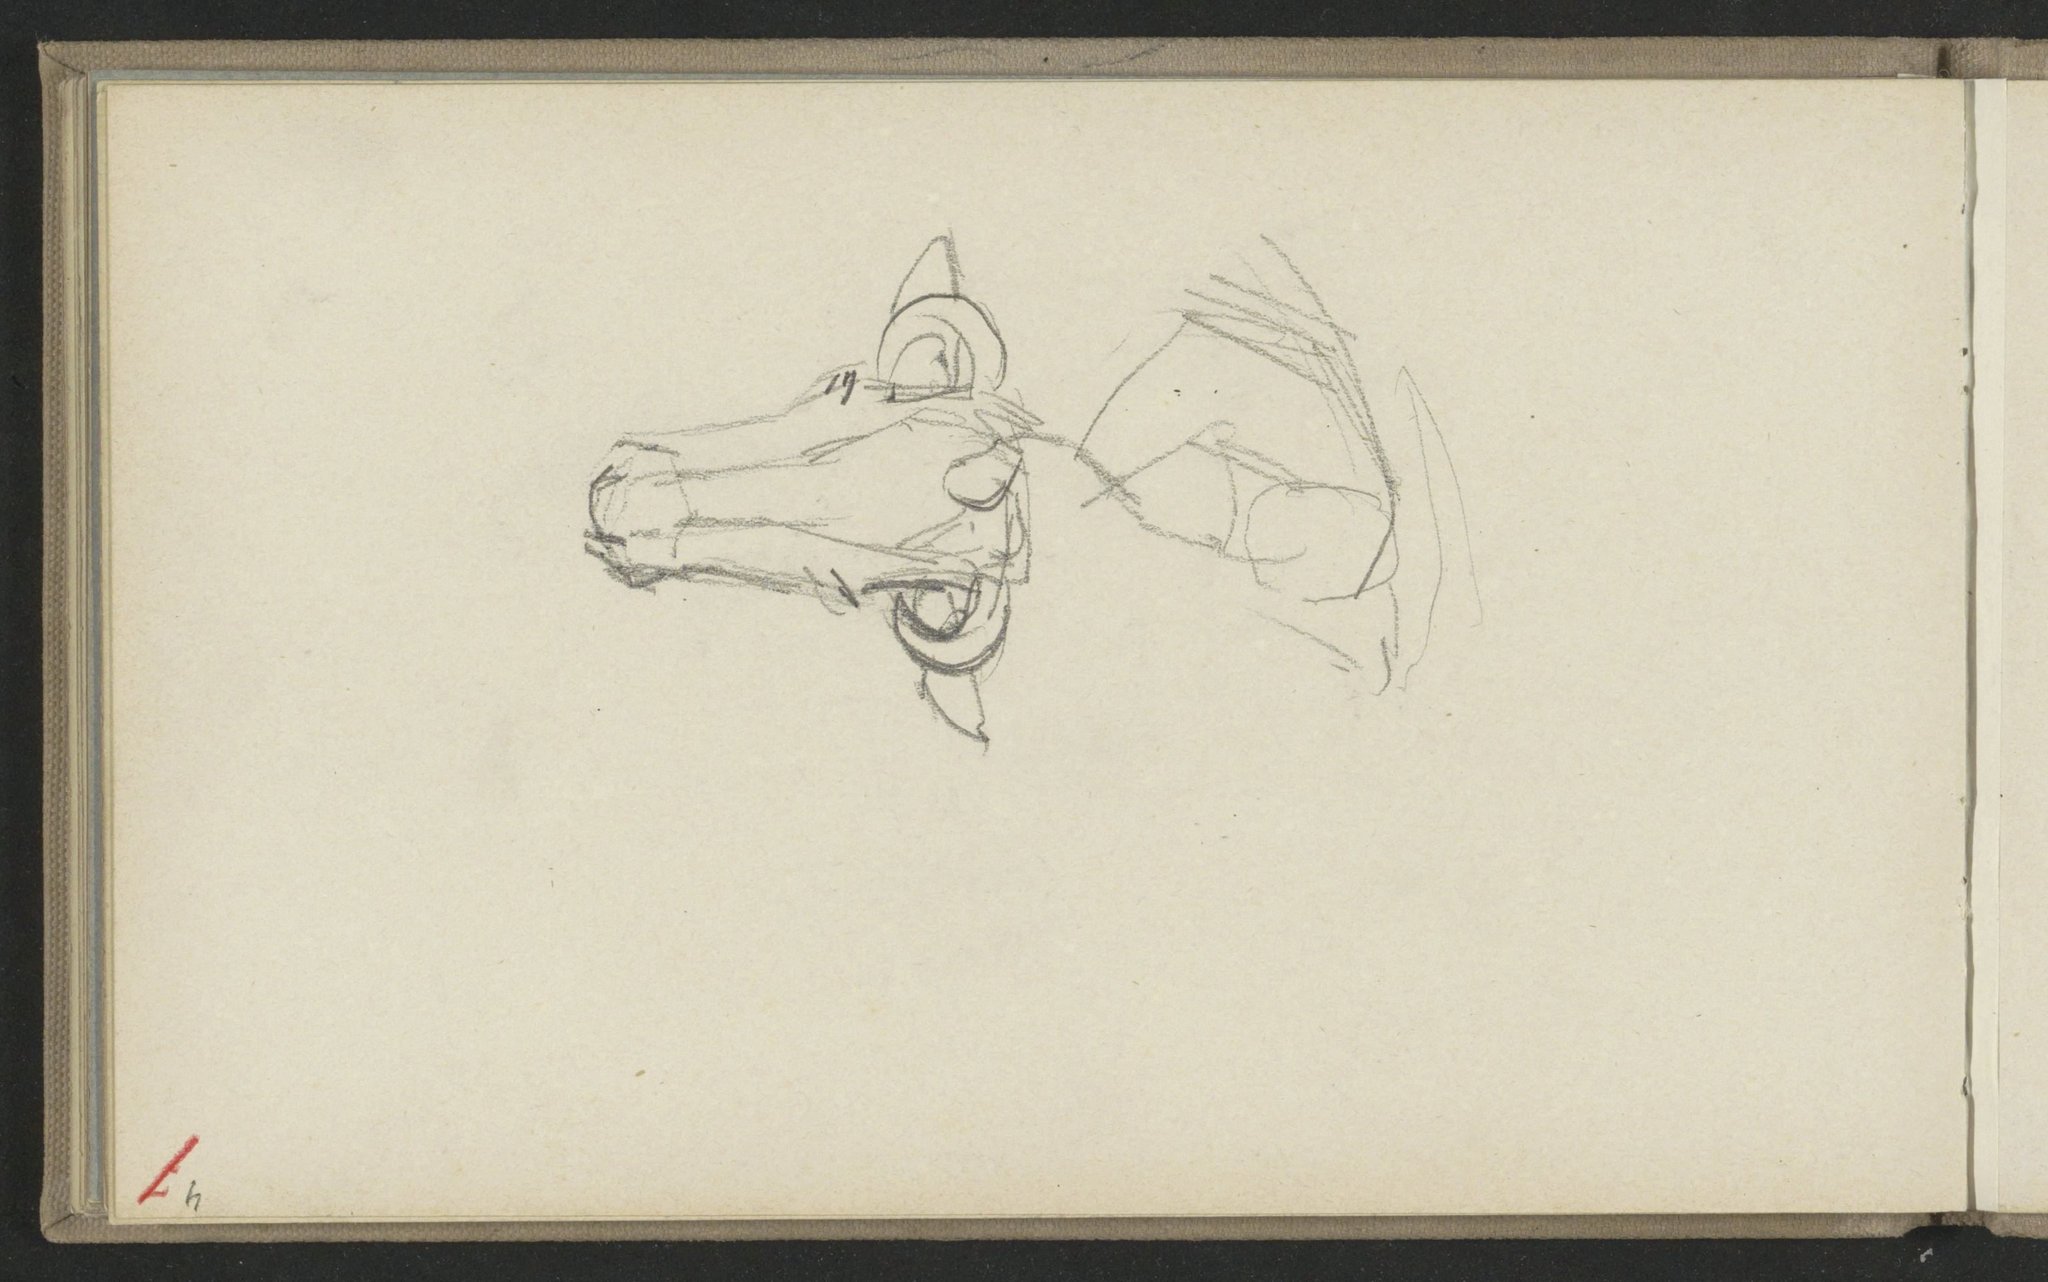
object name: sketchbook leaf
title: Kop van een koe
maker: jozef israëls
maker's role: draughtsman, painter, print maker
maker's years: 1824-1911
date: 1834-1911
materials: paper, pencil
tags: cow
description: Blad 22 verso uit een schetsboek met 26 bladen.